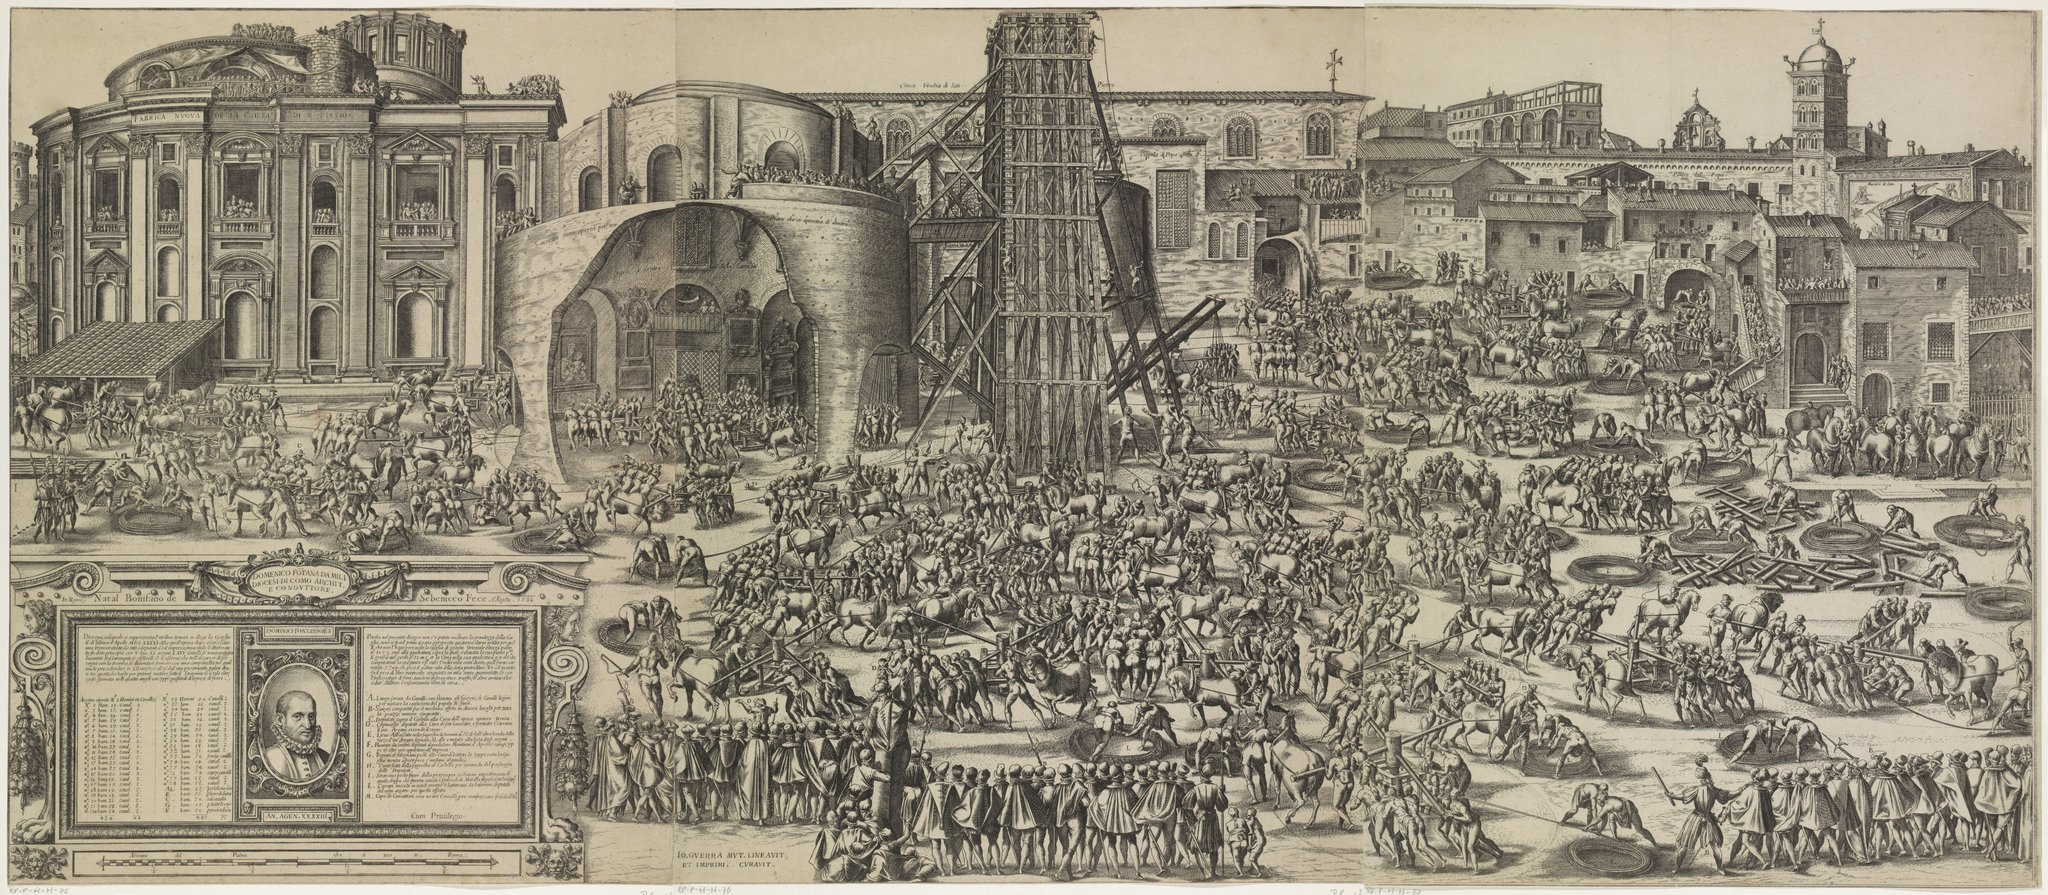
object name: print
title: De oprichting van de obelisk op het St. Pietersplein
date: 1586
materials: paper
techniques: engraving, etching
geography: rome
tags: switzerland, domenico fontana, obelisk, needle, historical persons, roman catholic church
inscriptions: collector's mark: ‘Hinloopen’, collector's mark: Lugt 11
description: Mannen en paarden zijn voor de Sint-Pietersbasiliek bezig met het oprichten van de Vaticaanse Obelisk (in 1586) op het St. Pietersplein. Linksonder een verklarende lijst met nummers en letters en het portret van Domenico Fontana, de architect die de hele verplaatsing en oprichting van de obelisk overzag.